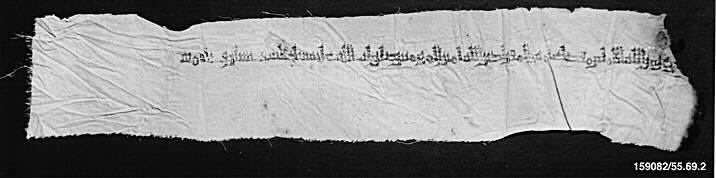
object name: textile fragment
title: Tiraz Fragment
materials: linen, silk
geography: egypt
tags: arabic